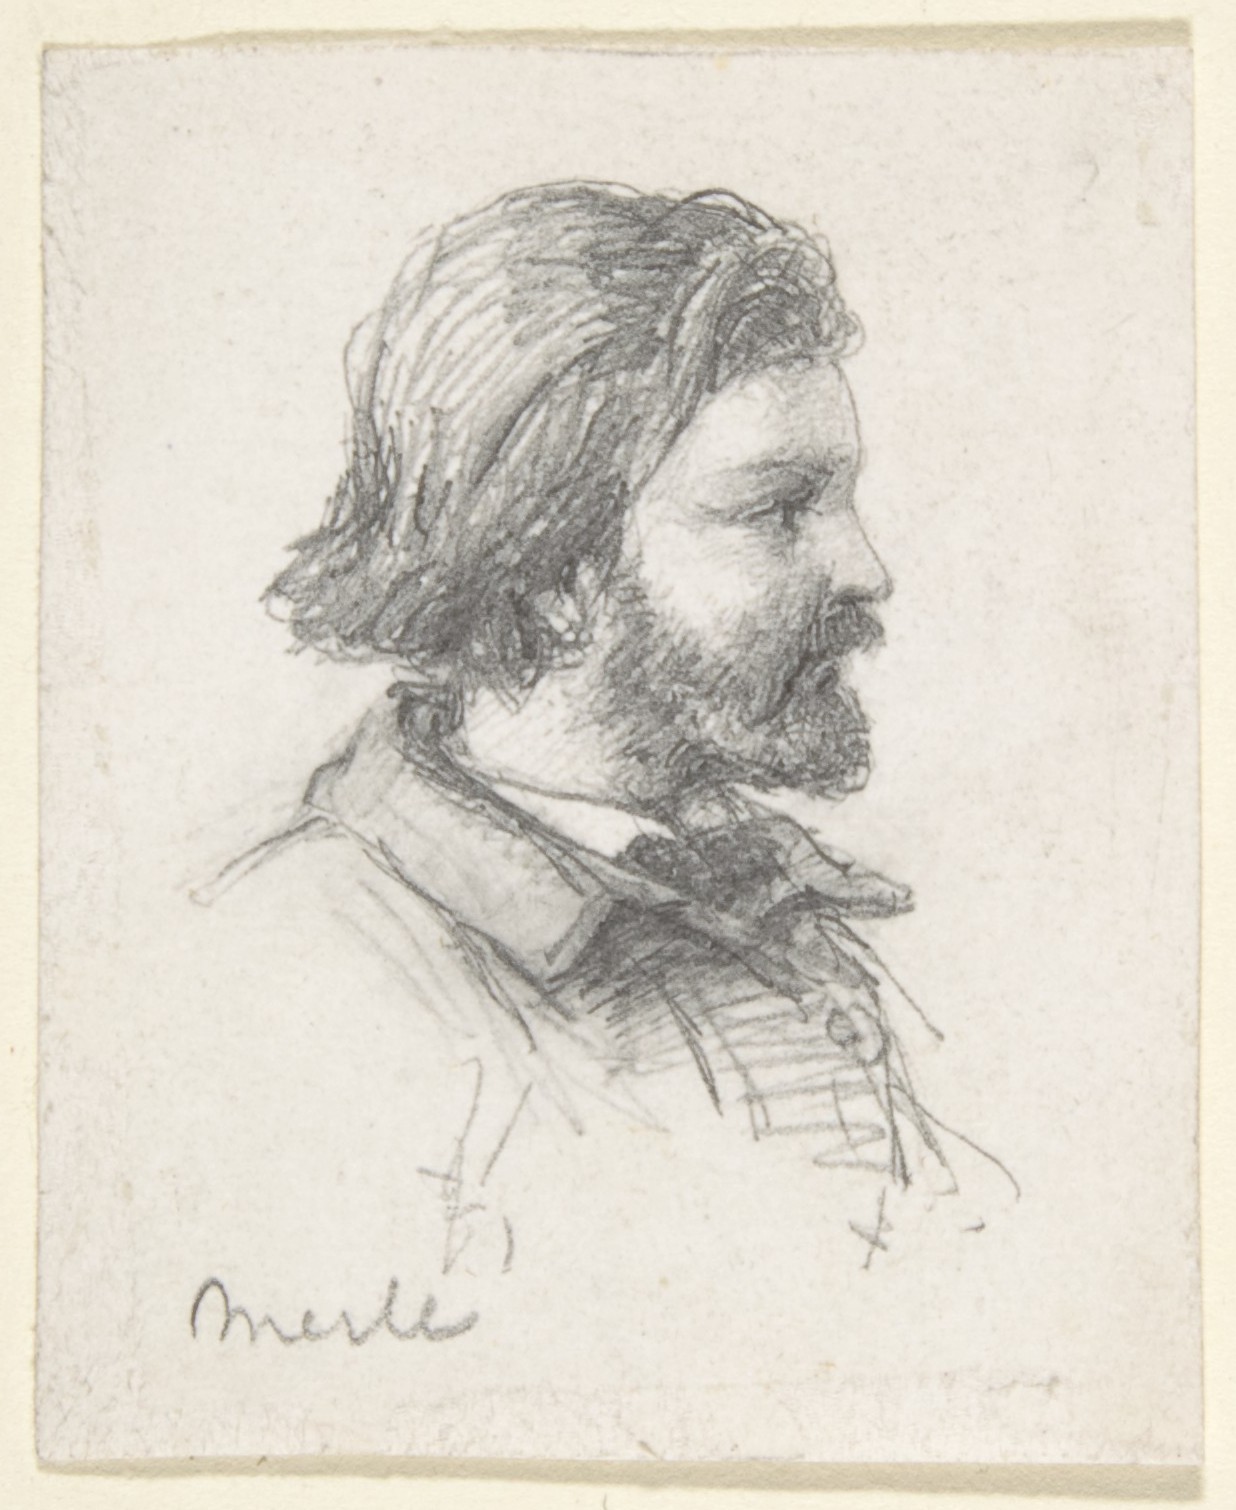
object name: drawing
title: Portrait of Merle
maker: anonymous, french, 19th century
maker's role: artist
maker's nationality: french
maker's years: 1800-1900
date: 1801-1900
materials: graphite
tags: men,portraits